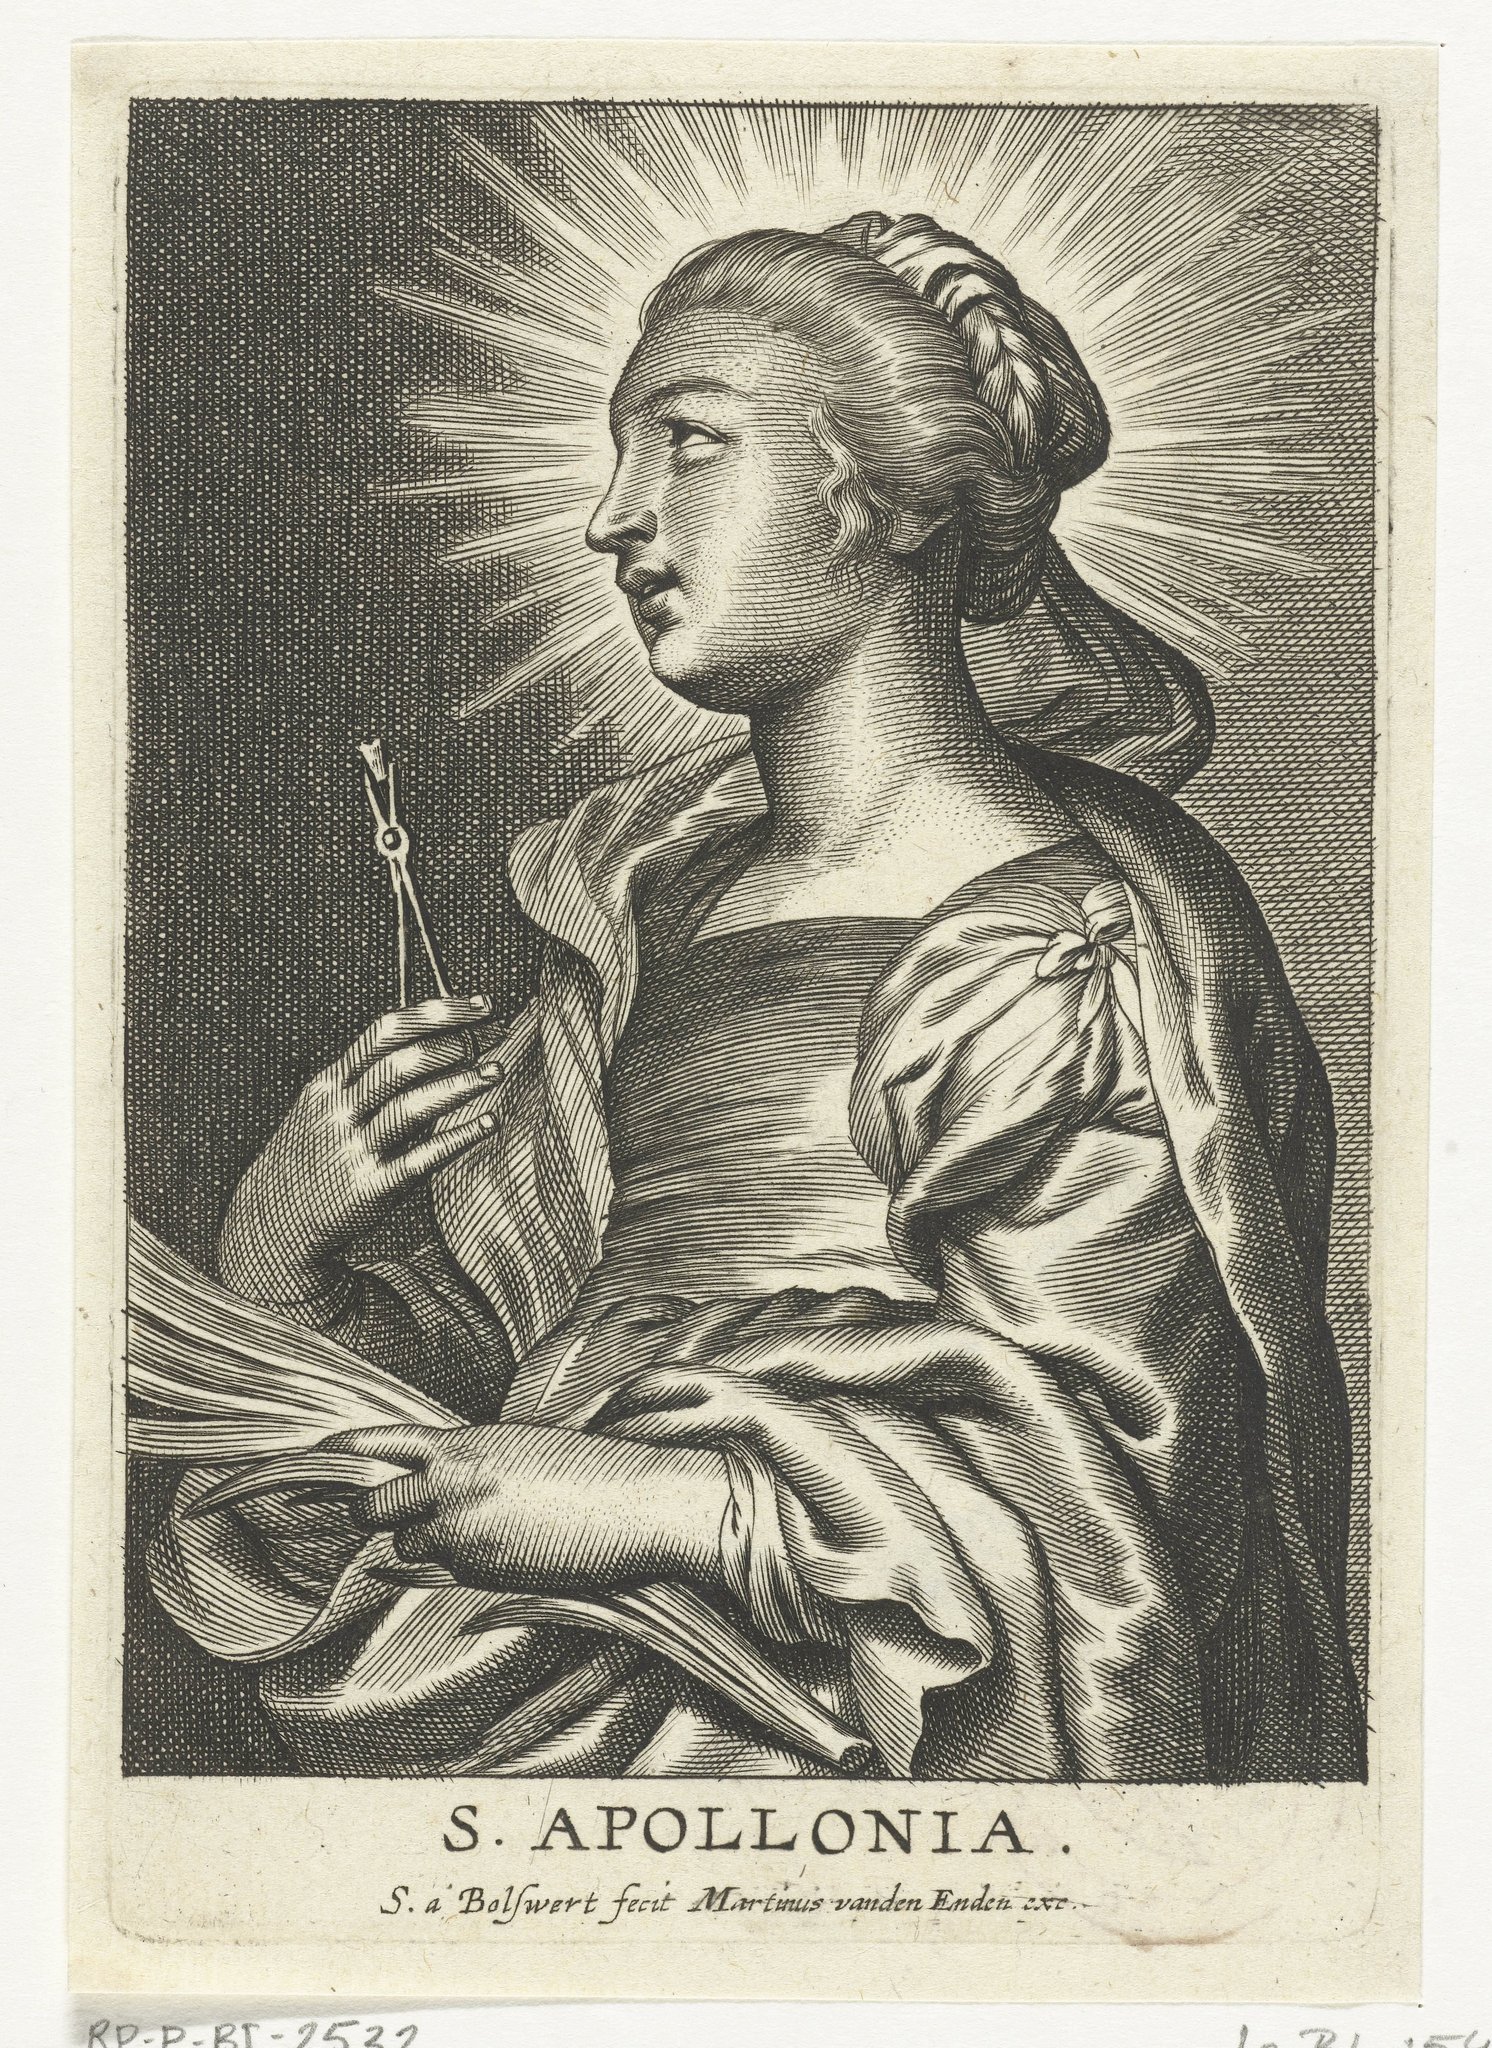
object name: print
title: S. Apollonia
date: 1596-1659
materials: paper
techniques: engraving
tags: the virgin martyr apollonia of alexandria; possible attributes: book, crown, palm-branch, tooth in pincers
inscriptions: collector's mark: Lugt 240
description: Prent naar ontwerp van Peter Paul Rubens.